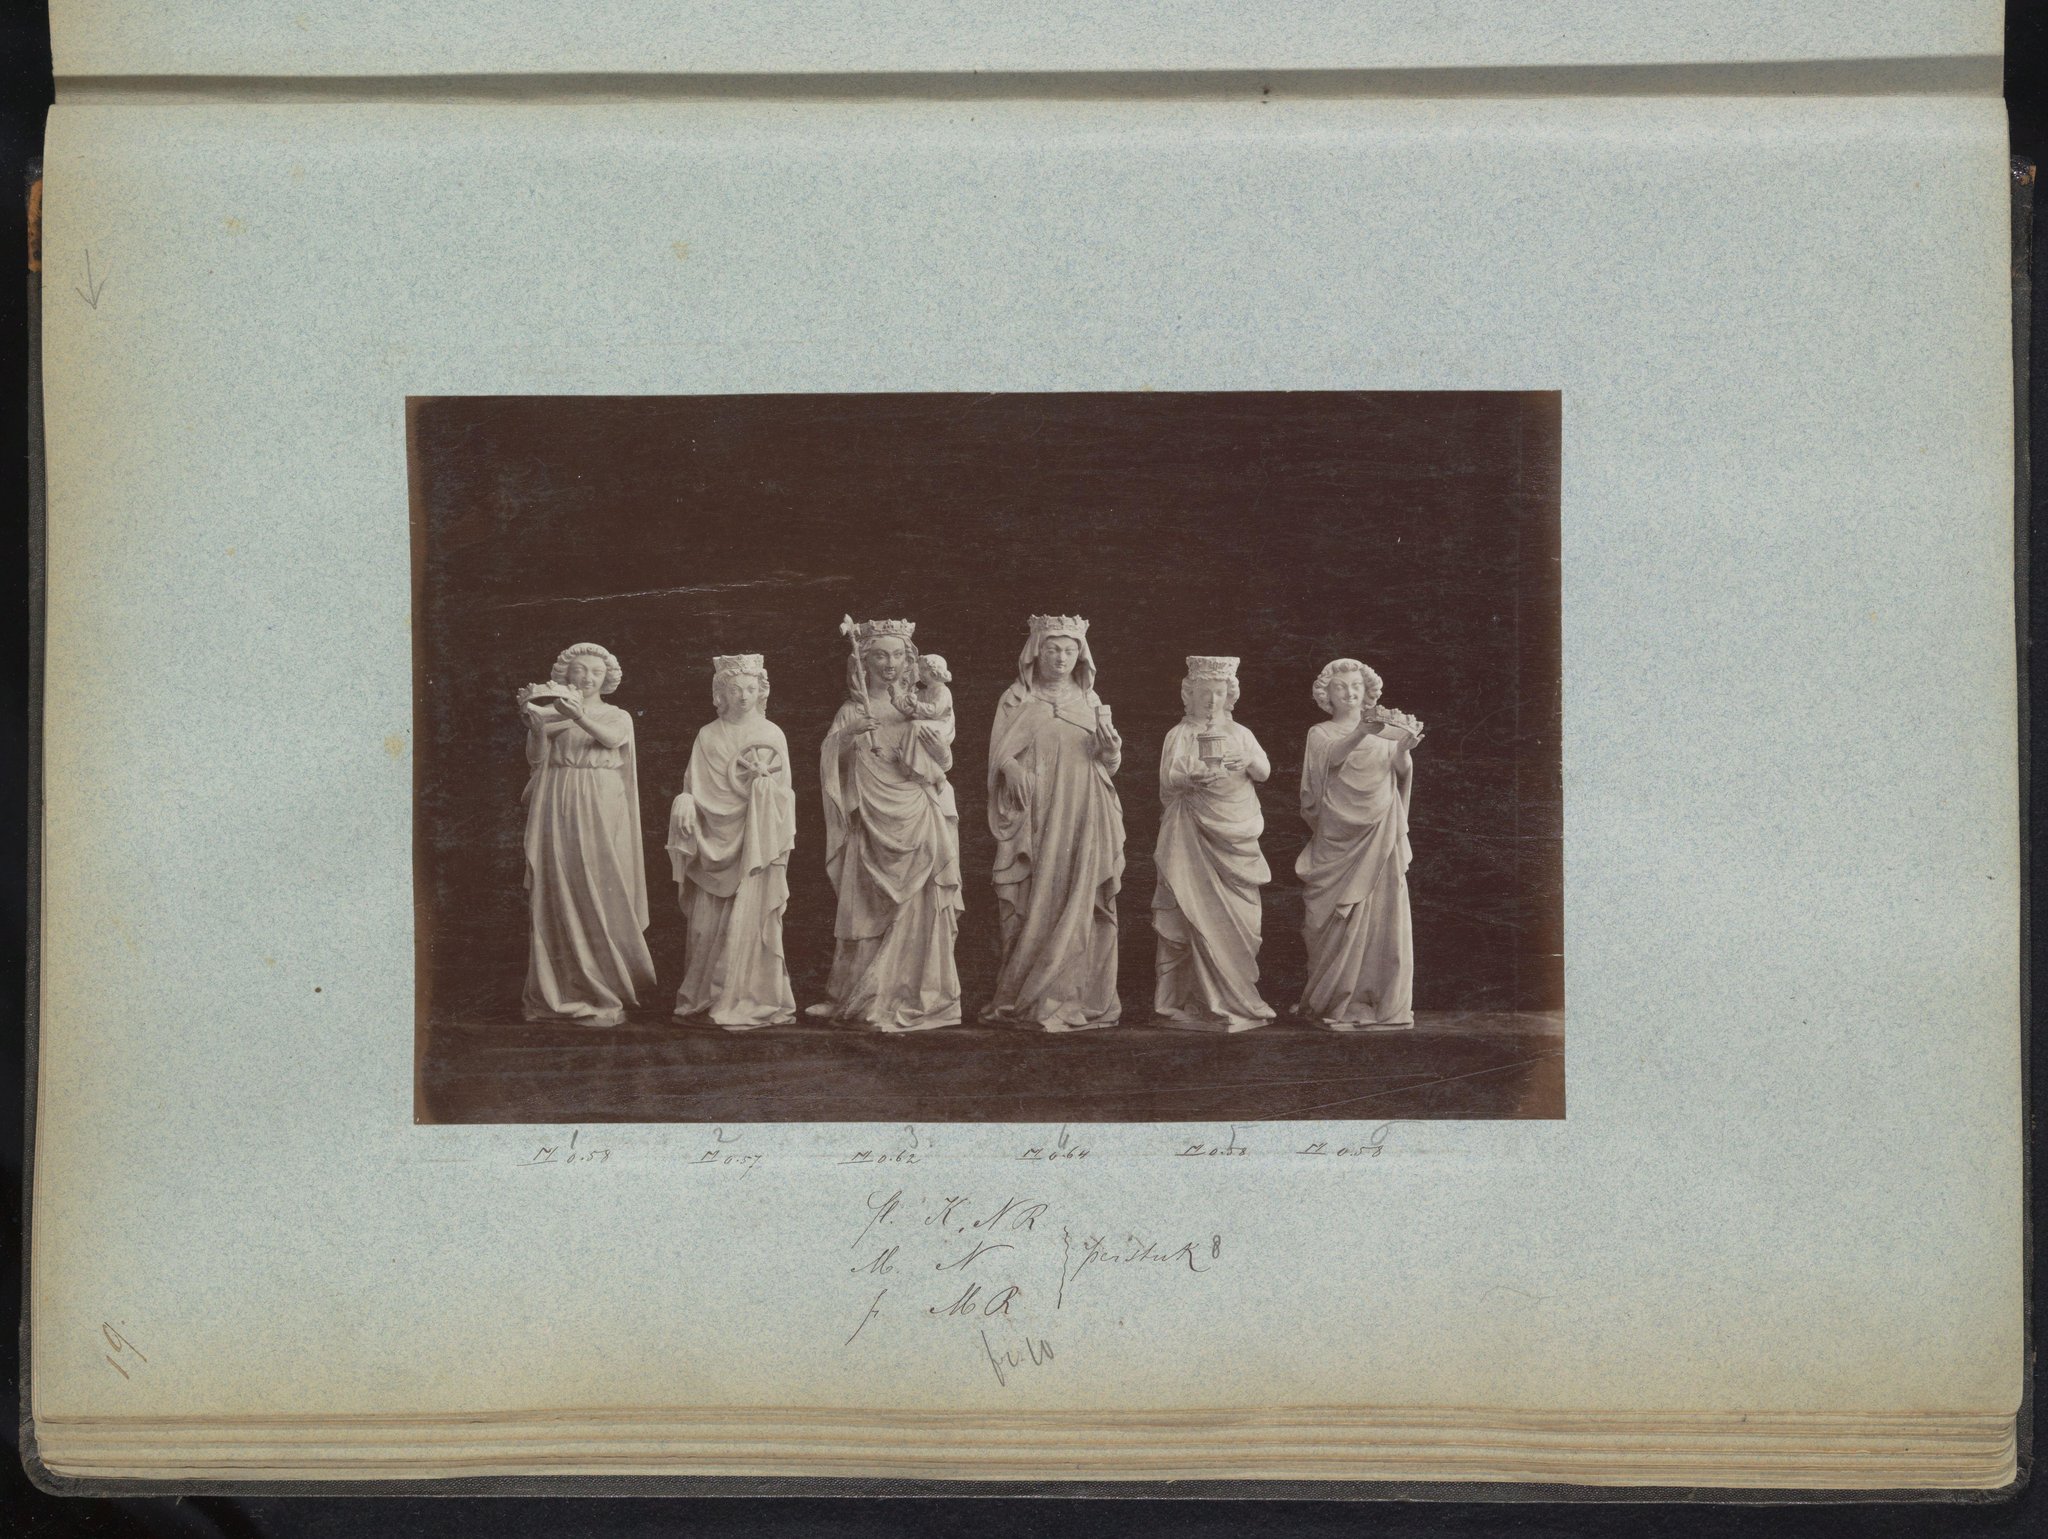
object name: photograph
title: Zes gipsen afgietsels van sculpturen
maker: Anonymous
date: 1875-1900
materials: paper, photographic support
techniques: albumen print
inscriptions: annotation, annotation: ‘M 0.58 M 0.57 M 0.62 M 0.64 M 0.58 M 0.58’